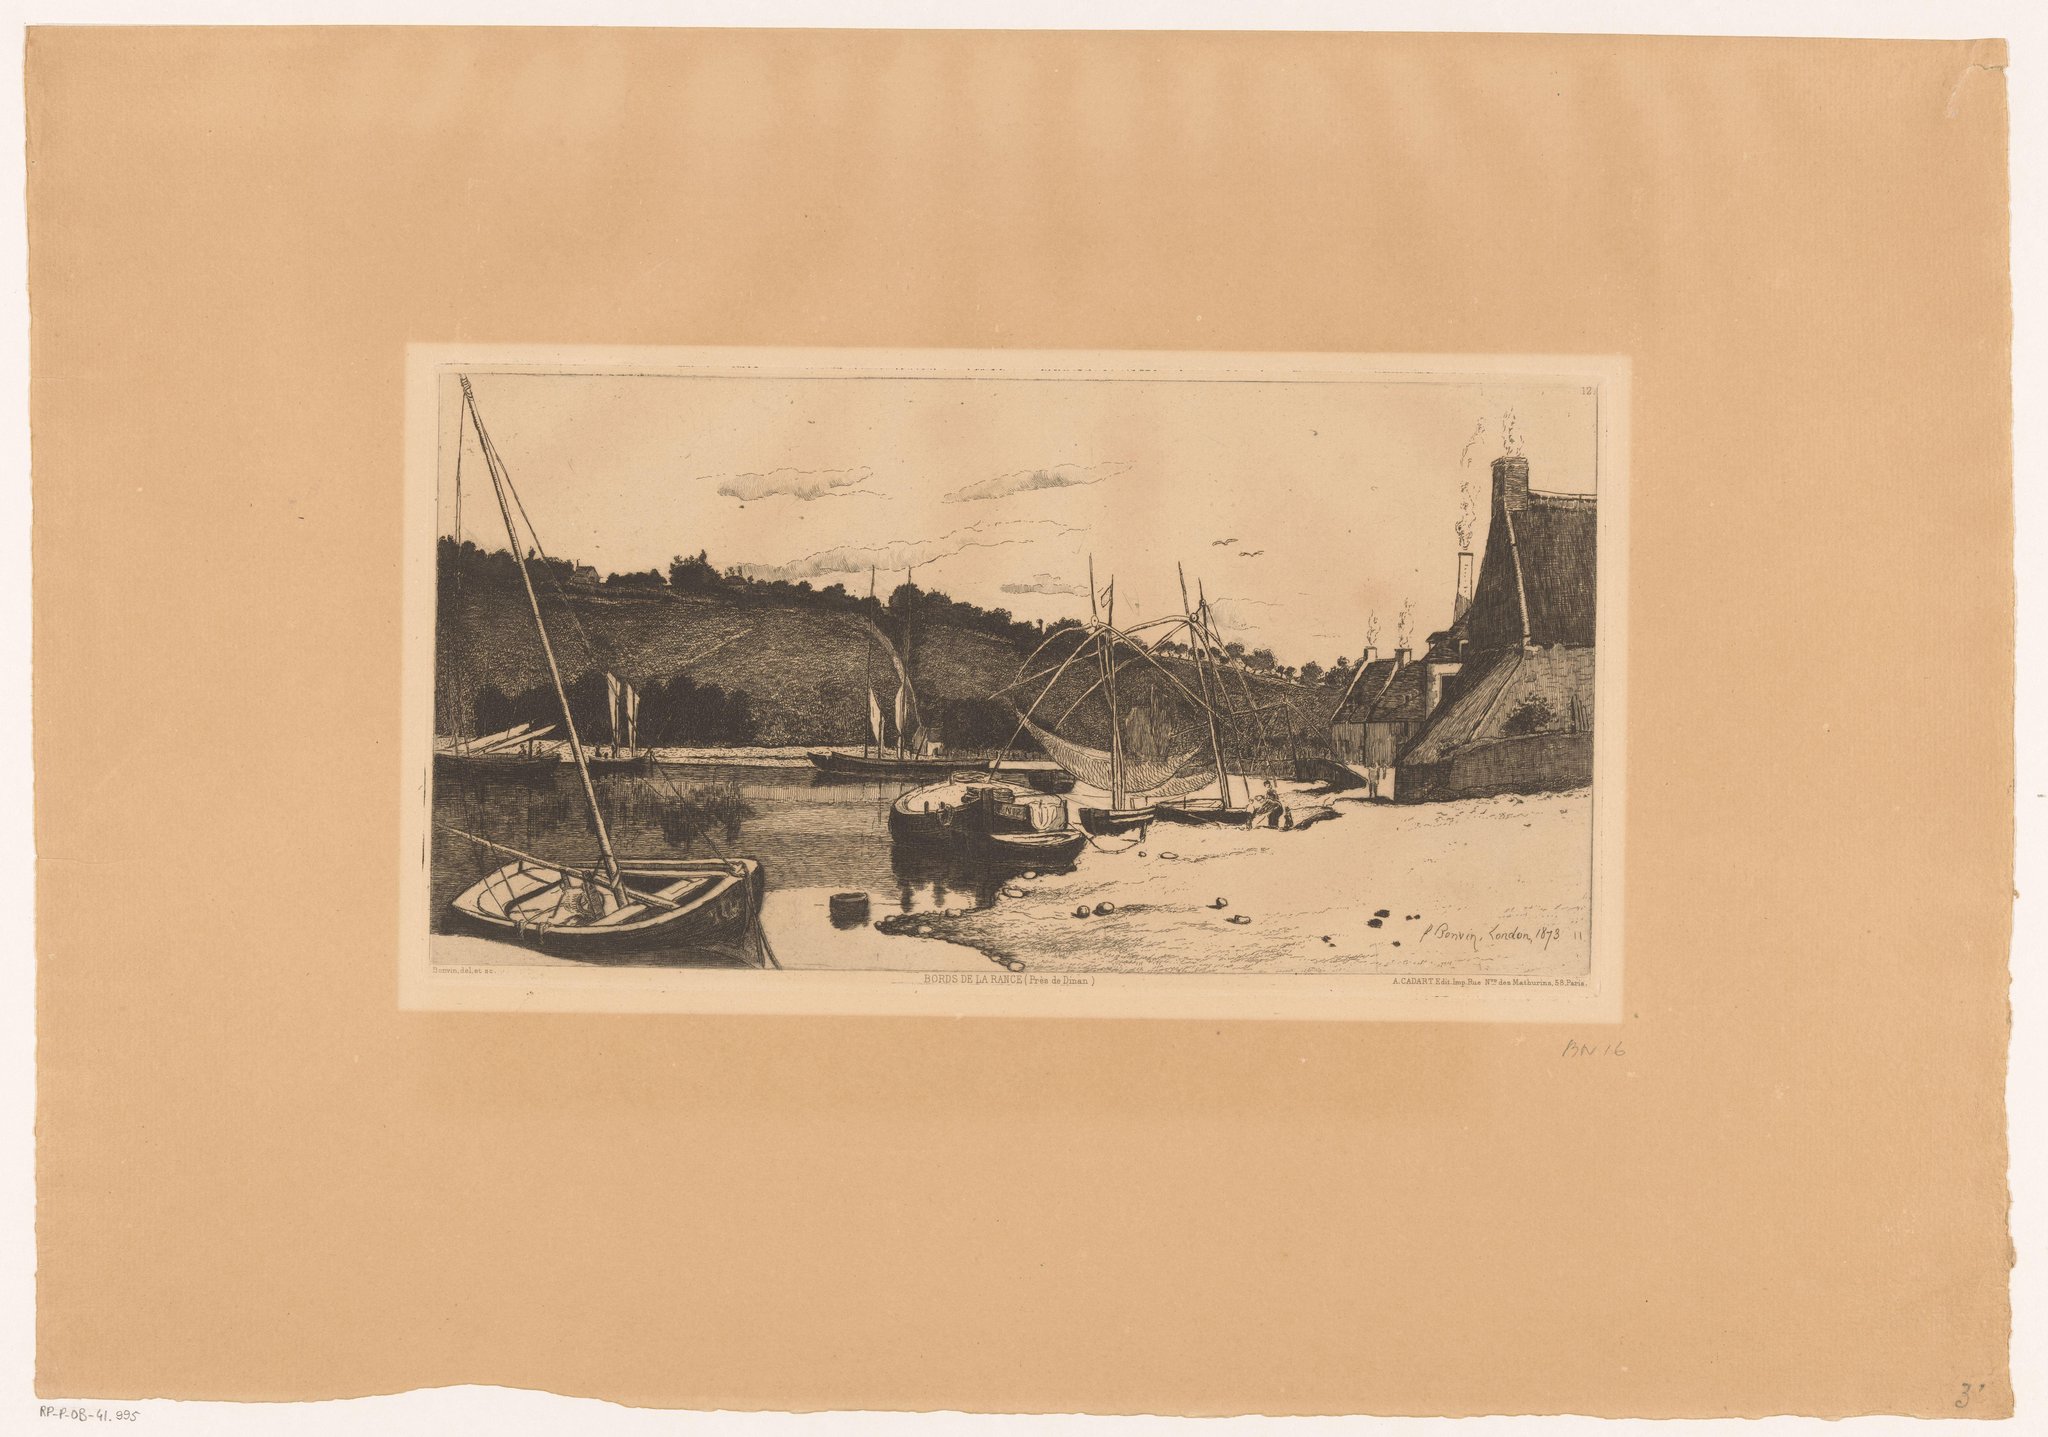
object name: print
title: Gezicht op de haven van Rance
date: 1873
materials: paper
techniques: etching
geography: paris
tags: harbour, ships, boats on land, beached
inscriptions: collector's mark: Lugt 2228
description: Maakt deel uit van een tiendelige serie, getiteld: Dix Eaux-fortes, dessinées et gravées par F. Bonvin, Peintre, uitgegeven door Cadart te Parijs in 1861 en te Londen in 1871.